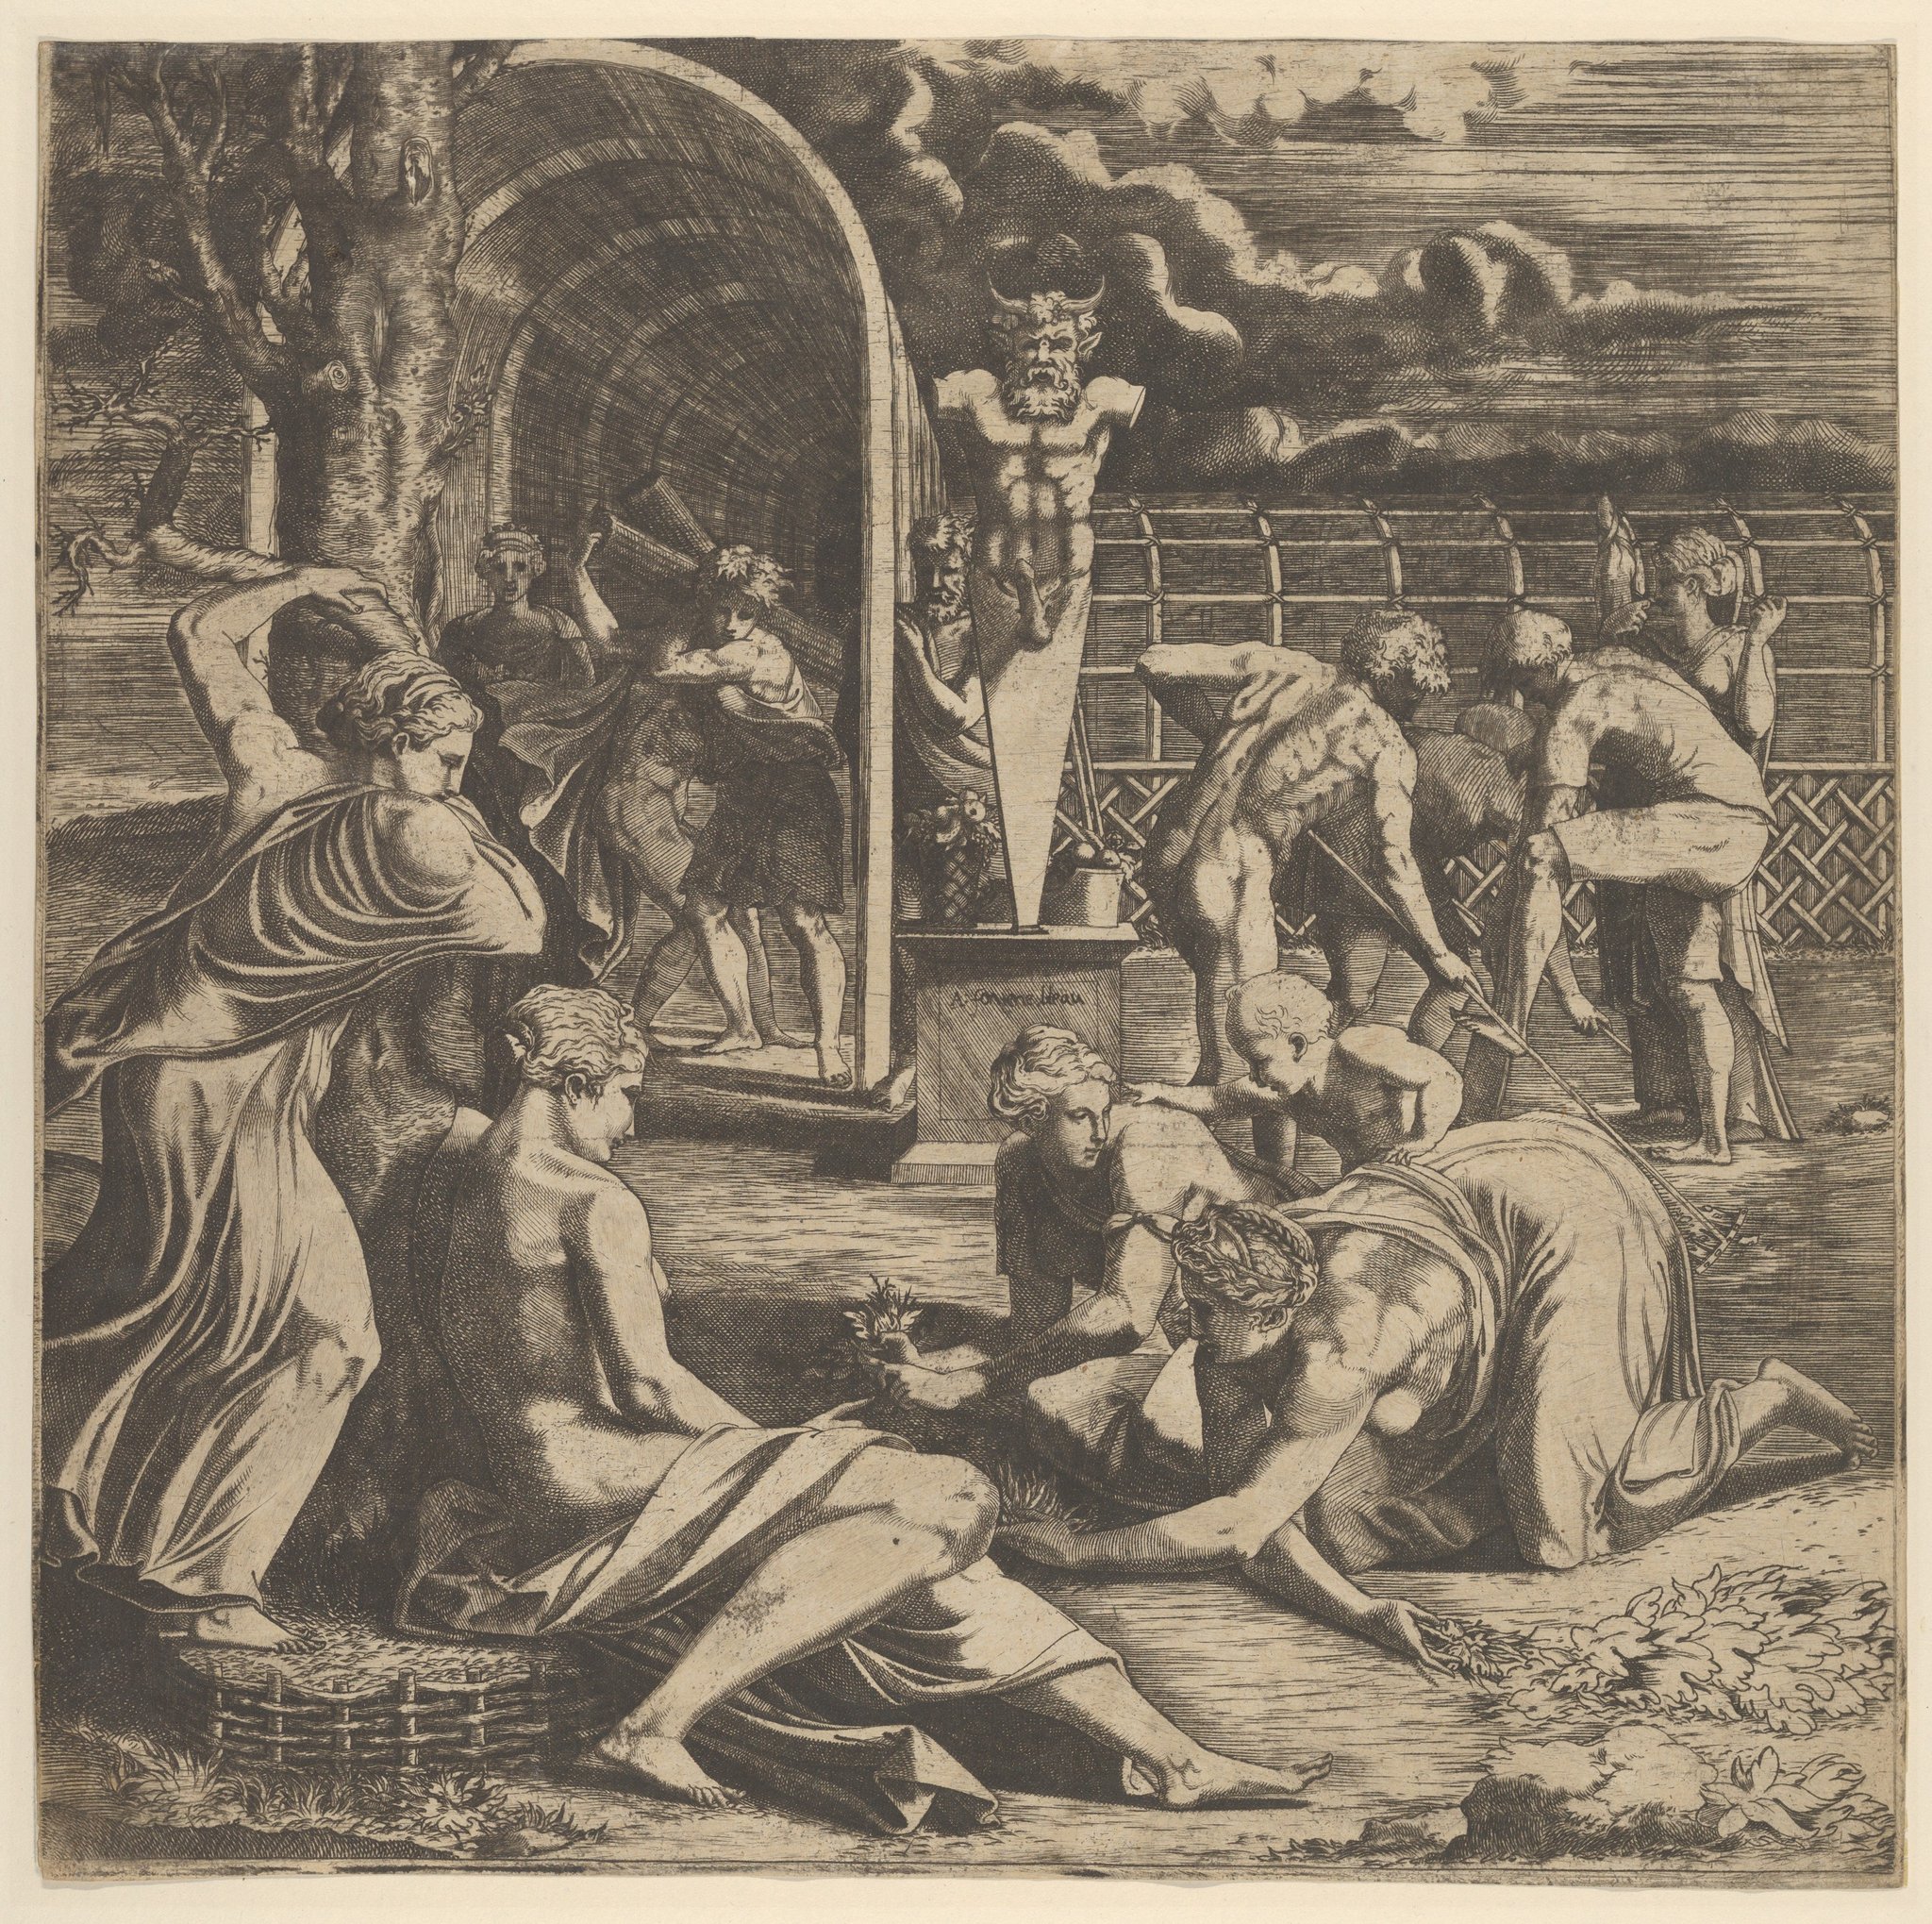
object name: print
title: The Garden of Pomona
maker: léon davent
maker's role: artist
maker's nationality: french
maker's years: 1540-1556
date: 1540-1556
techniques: engraving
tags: gardens,men,male nudes,women